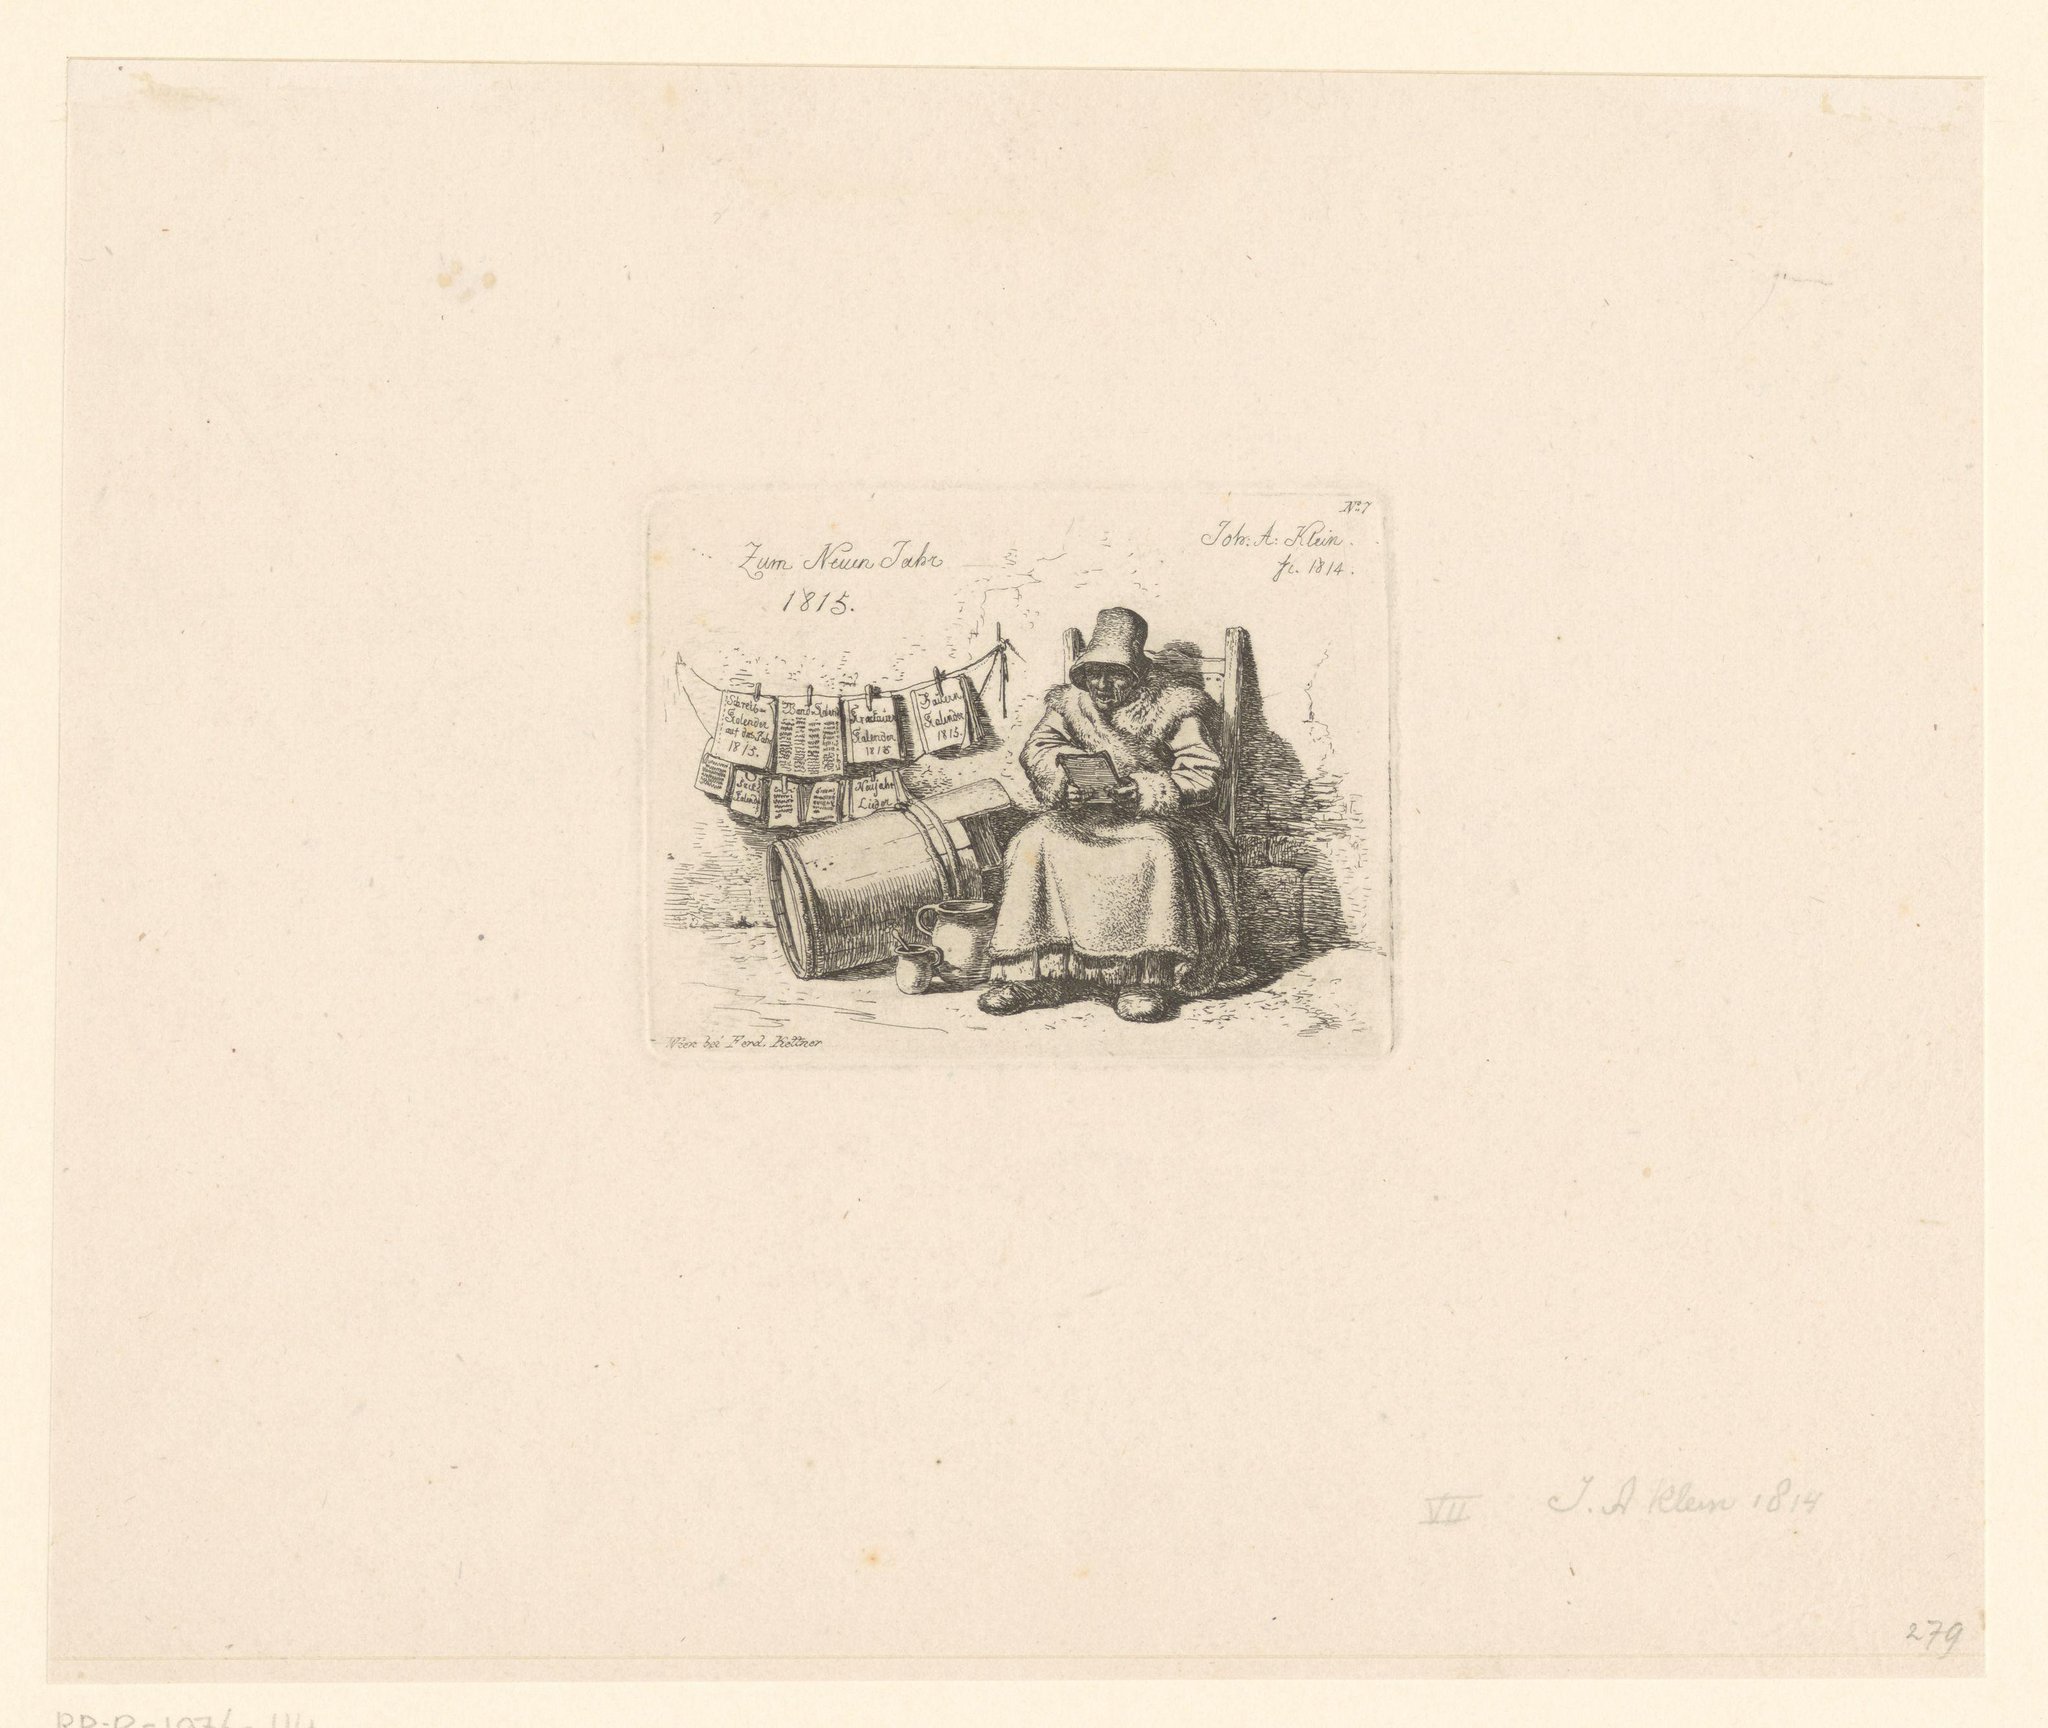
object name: print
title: Oude vrouw naast een waslijn met kalenders voor het jaar 1815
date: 1814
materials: paper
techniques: etching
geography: vienna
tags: calendar, almanac, new year's eve (december 31), old woman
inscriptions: collector's mark: Lugt 4731, collector's mark: Lugt 2228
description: Nieuwjaarskaart voor 1815, met tekst in het Duits bovenaan.